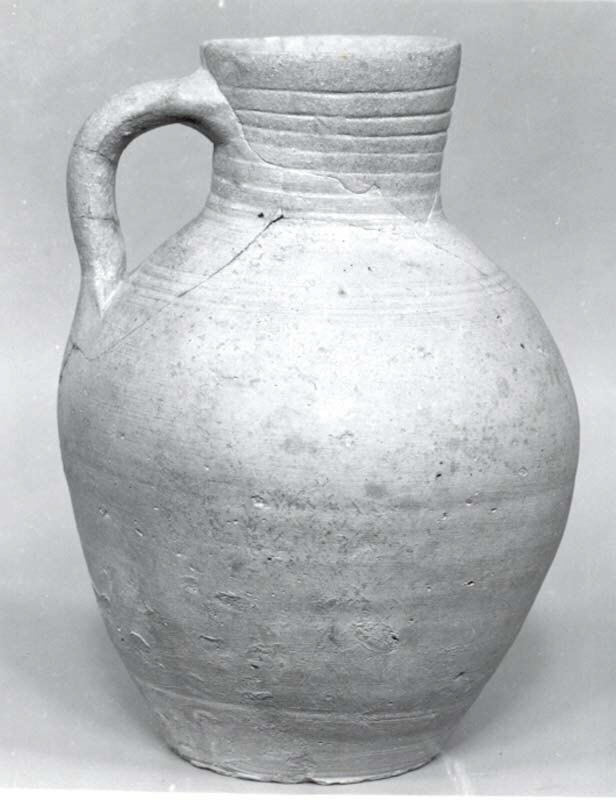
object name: jug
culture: sasanian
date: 201-700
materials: ceramic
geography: iran